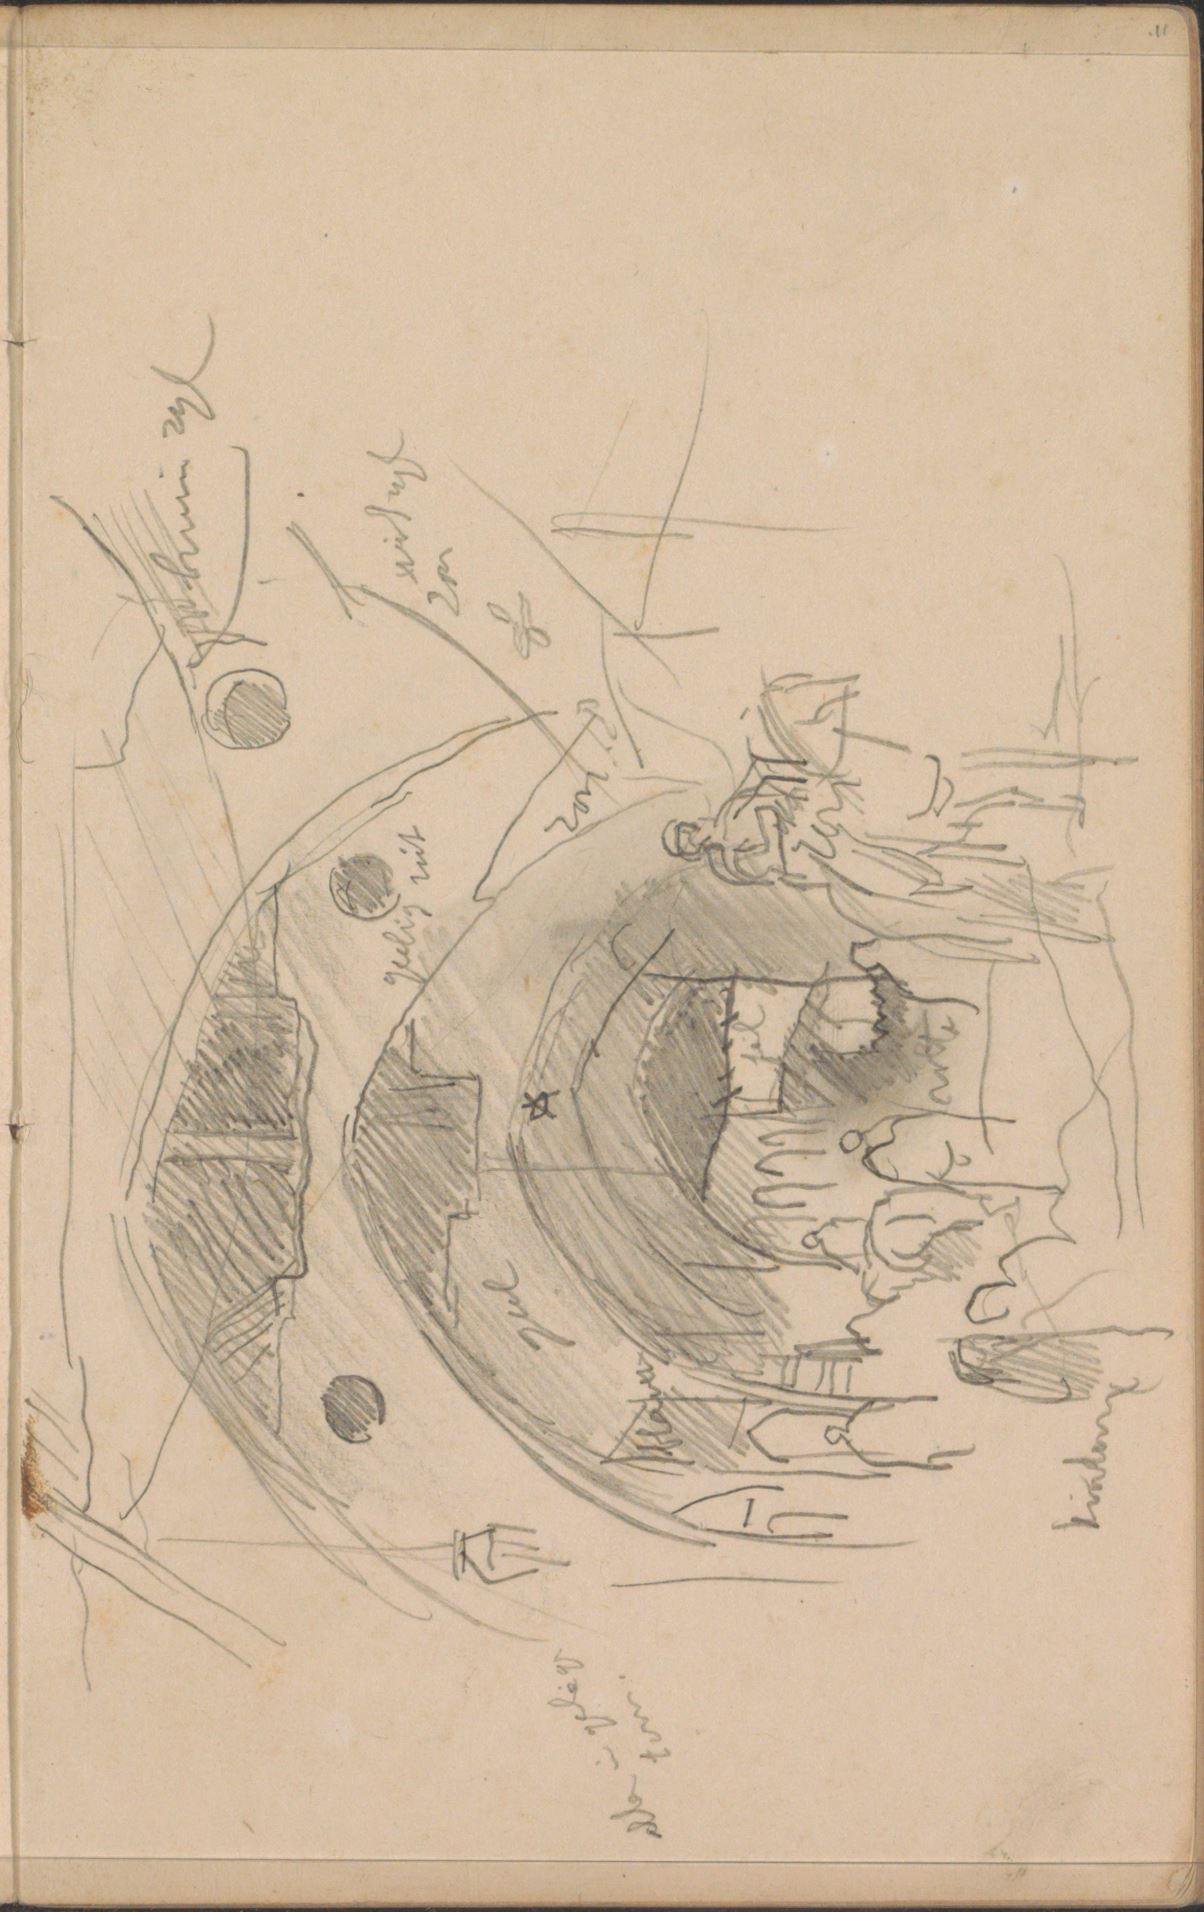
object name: sketchbook leaf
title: Overdekte straat met figuren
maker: marius bauer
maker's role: draughtsman, print maker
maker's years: 1867-1932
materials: paper, pencil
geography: jerusalem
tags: riding a horse, ass, or mule; rider, horseman, arch, archivolt ~ architecture, street (+ city(-scape) with figures, staffage)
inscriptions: kleurnotitie, handgeschreven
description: Pagina 11 uit een schetsboek met 36 bladen.